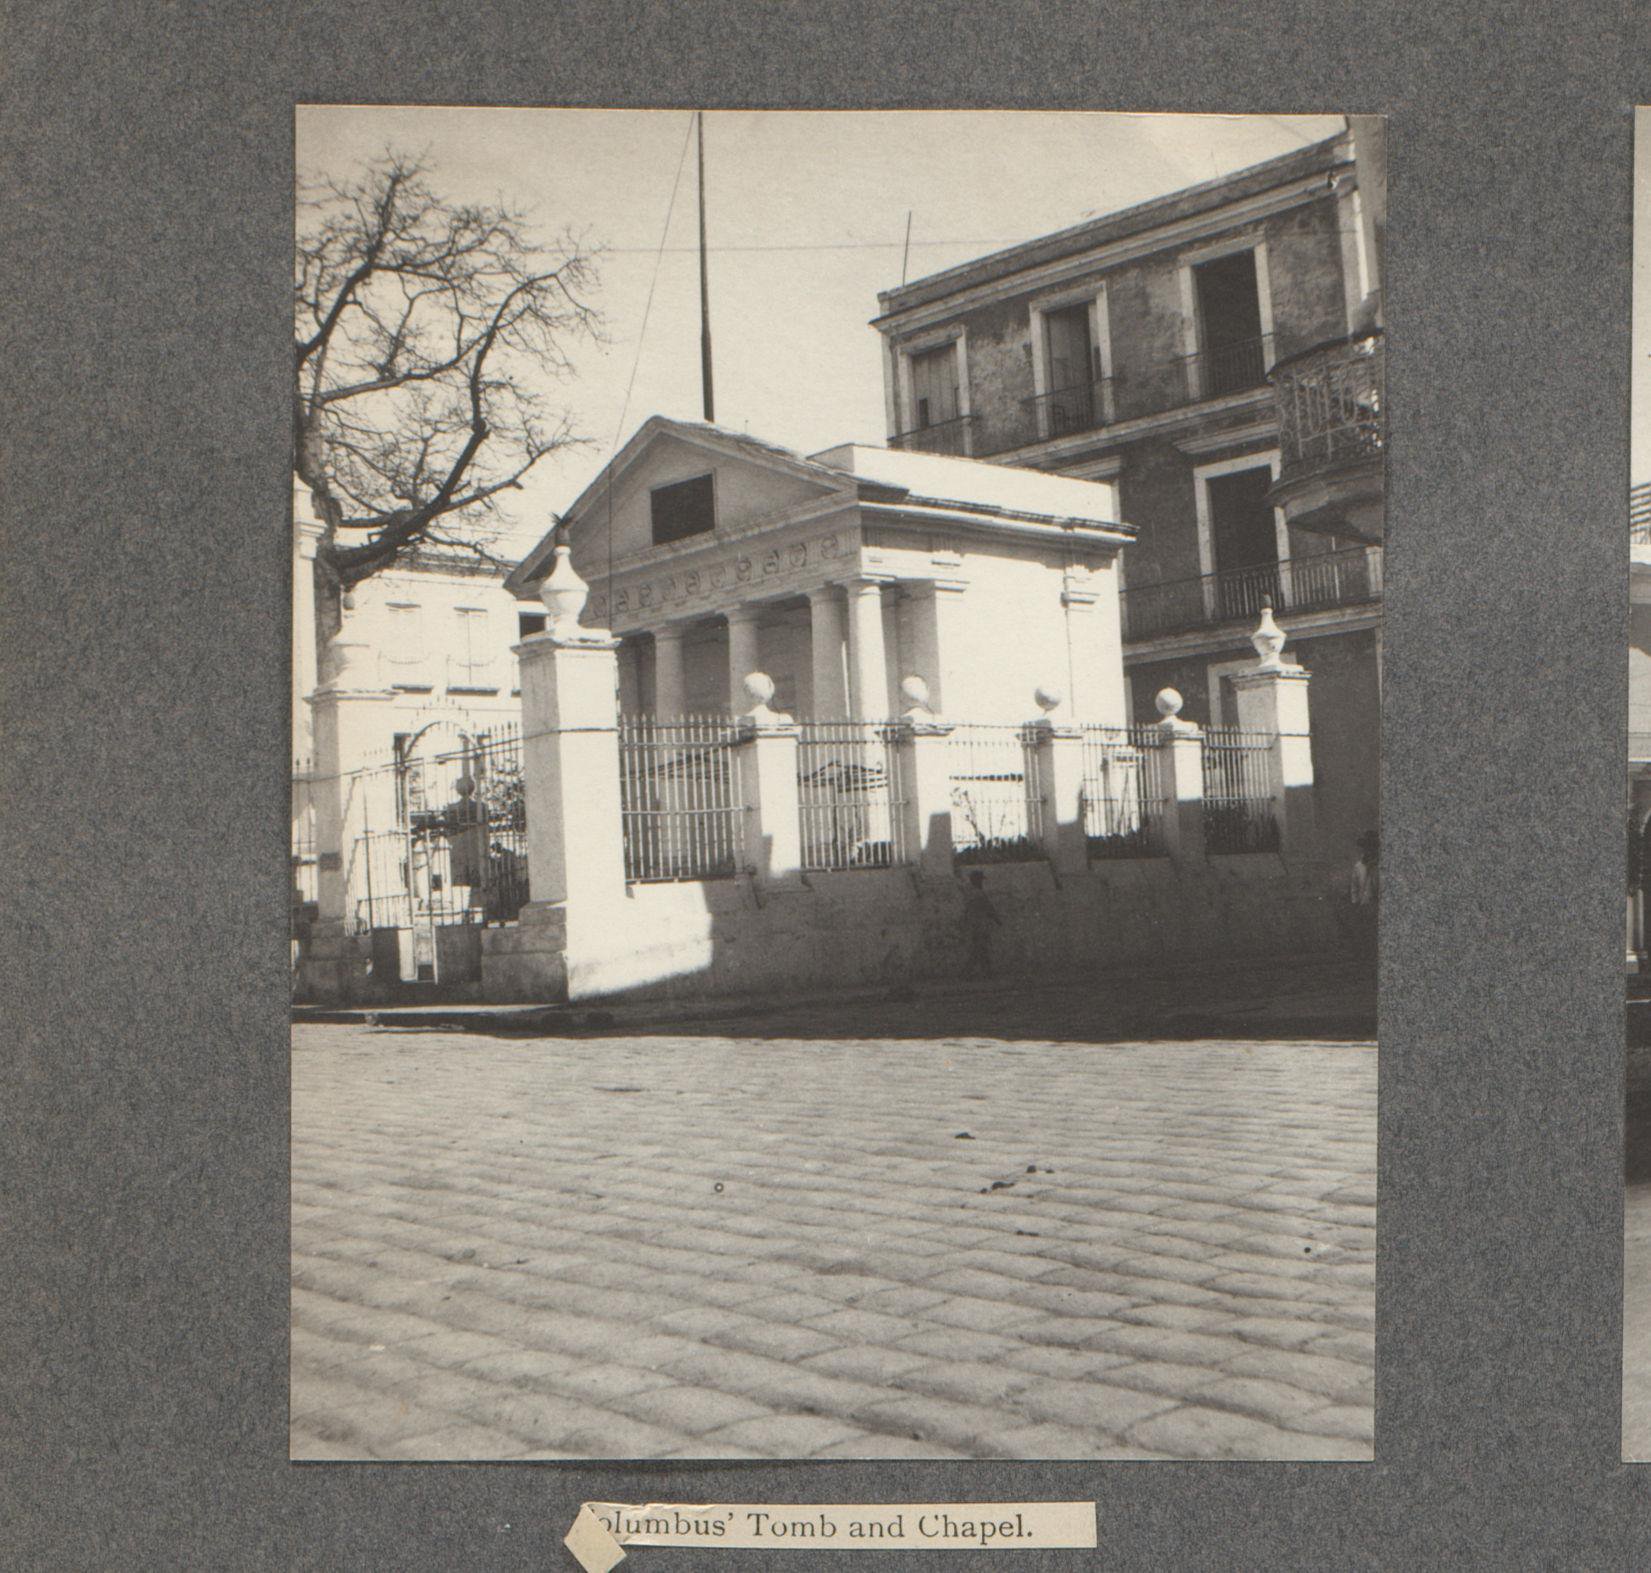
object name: album leaf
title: Tempel van Columbus in Havana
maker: Anonymous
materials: paper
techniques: platinum process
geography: havana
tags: monument, statue